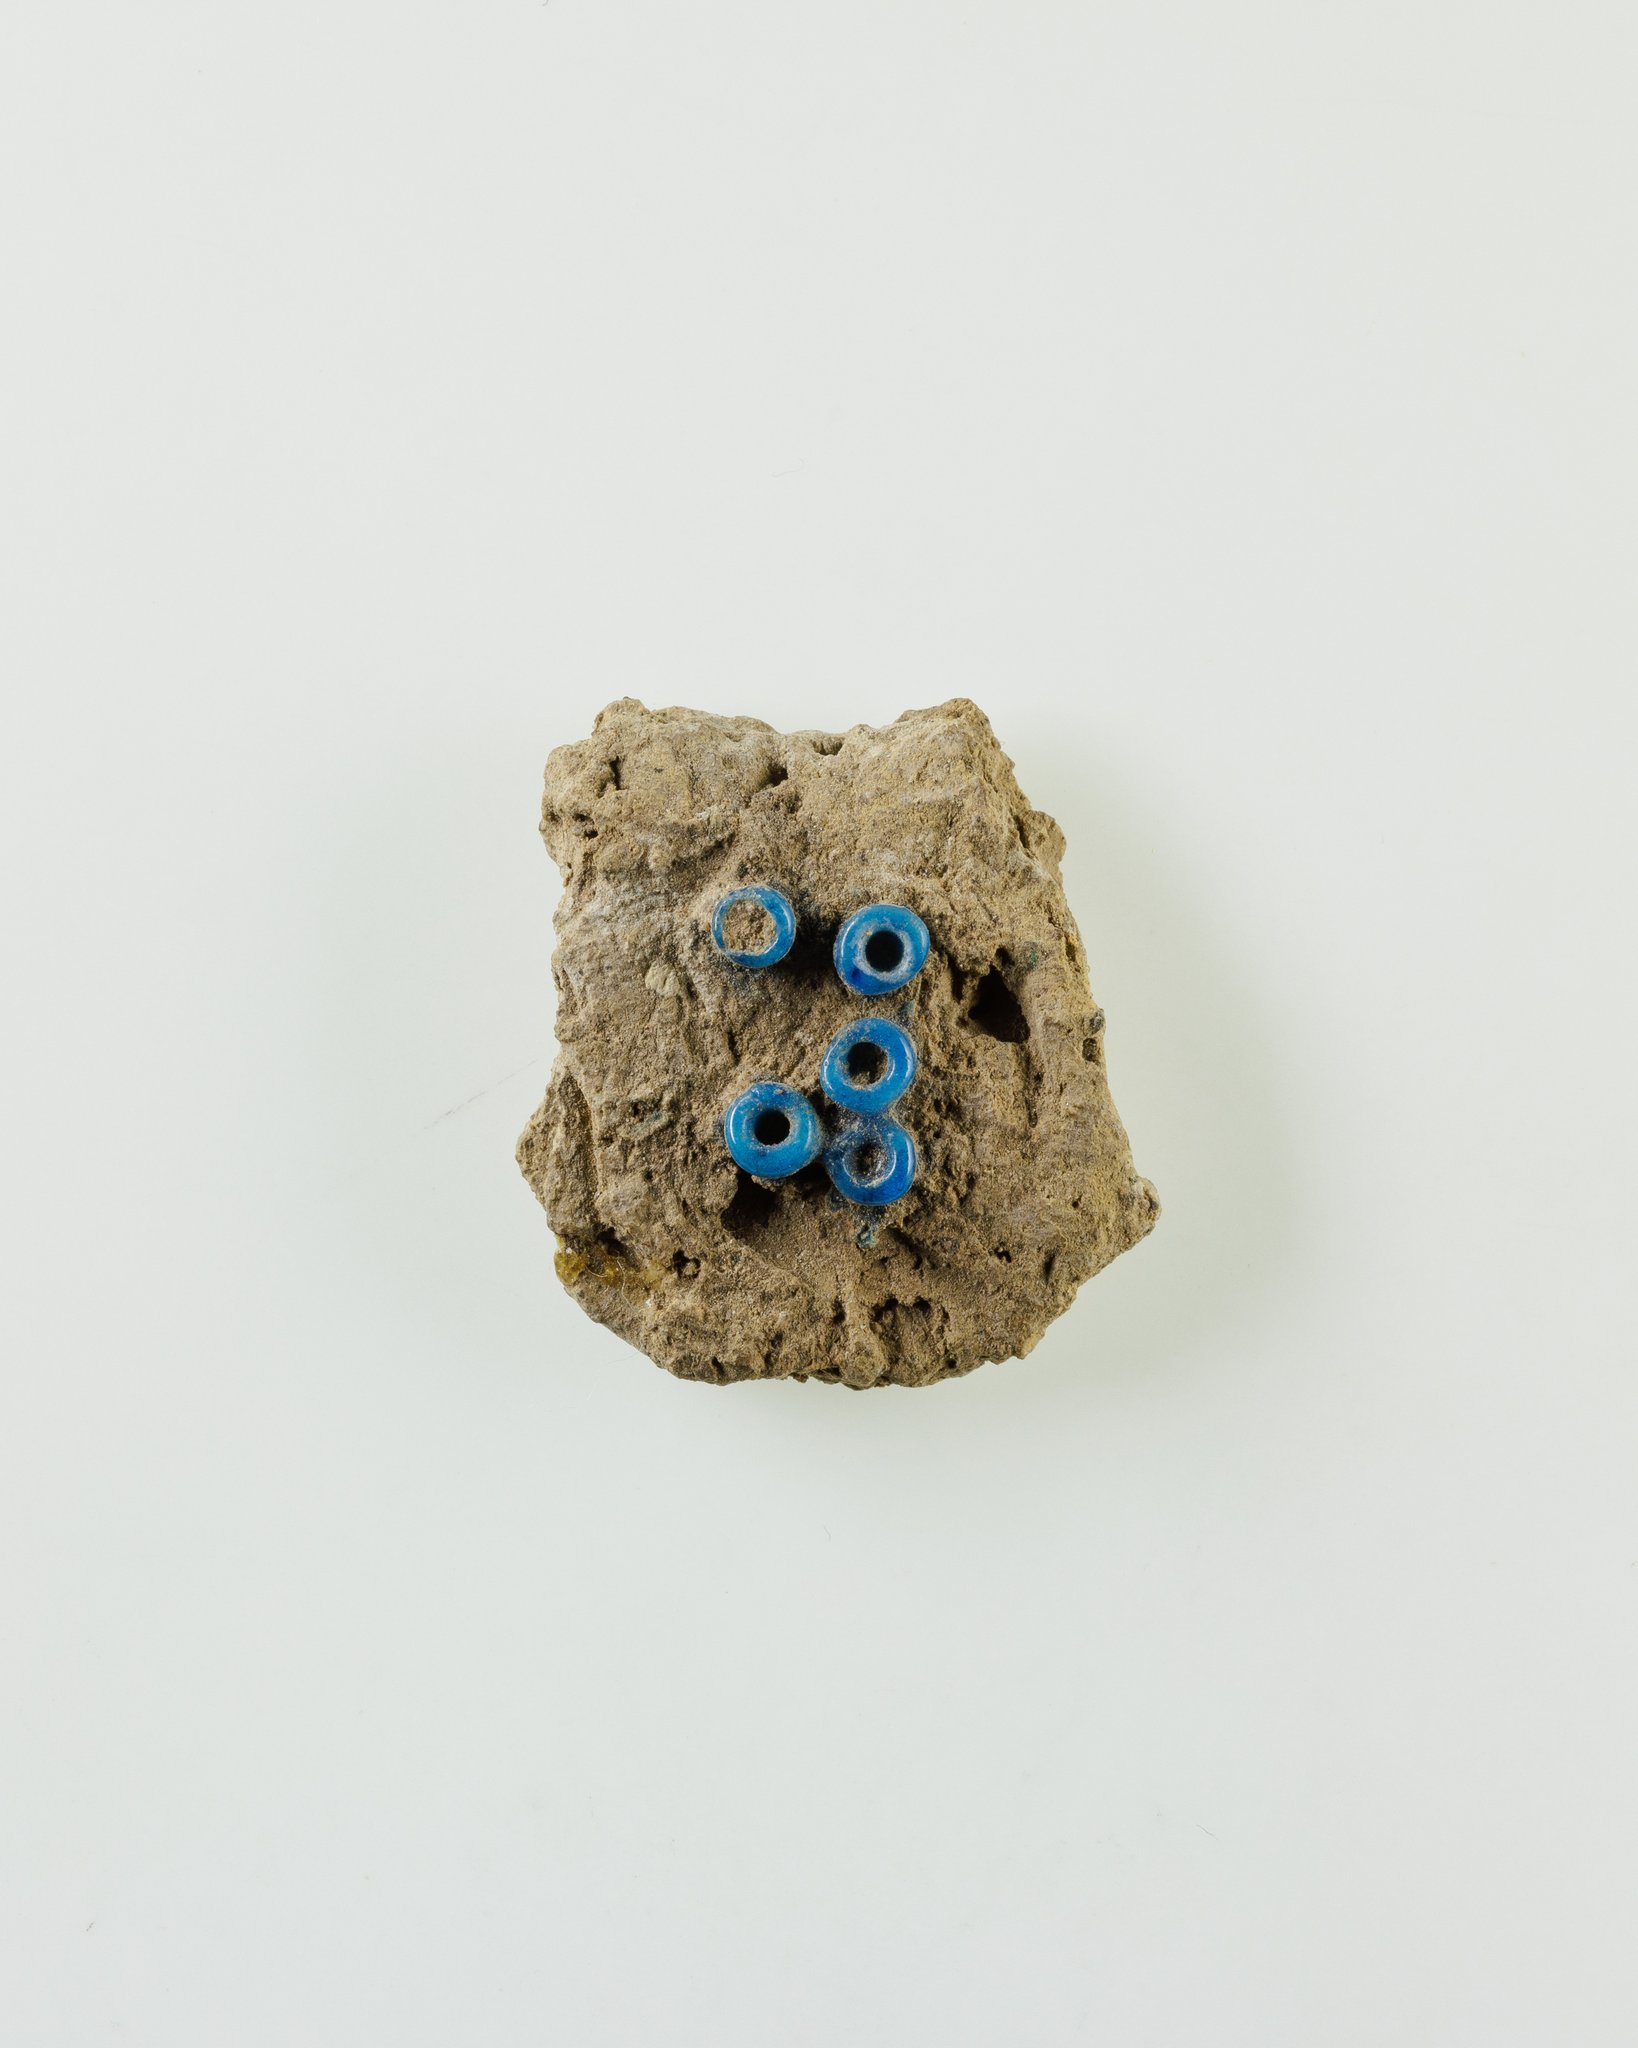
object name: fragment, clay, ring bead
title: Fragment of clay lump with imbedded ring beads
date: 1802-1450 BCE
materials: clay, faience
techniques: firing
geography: egypt